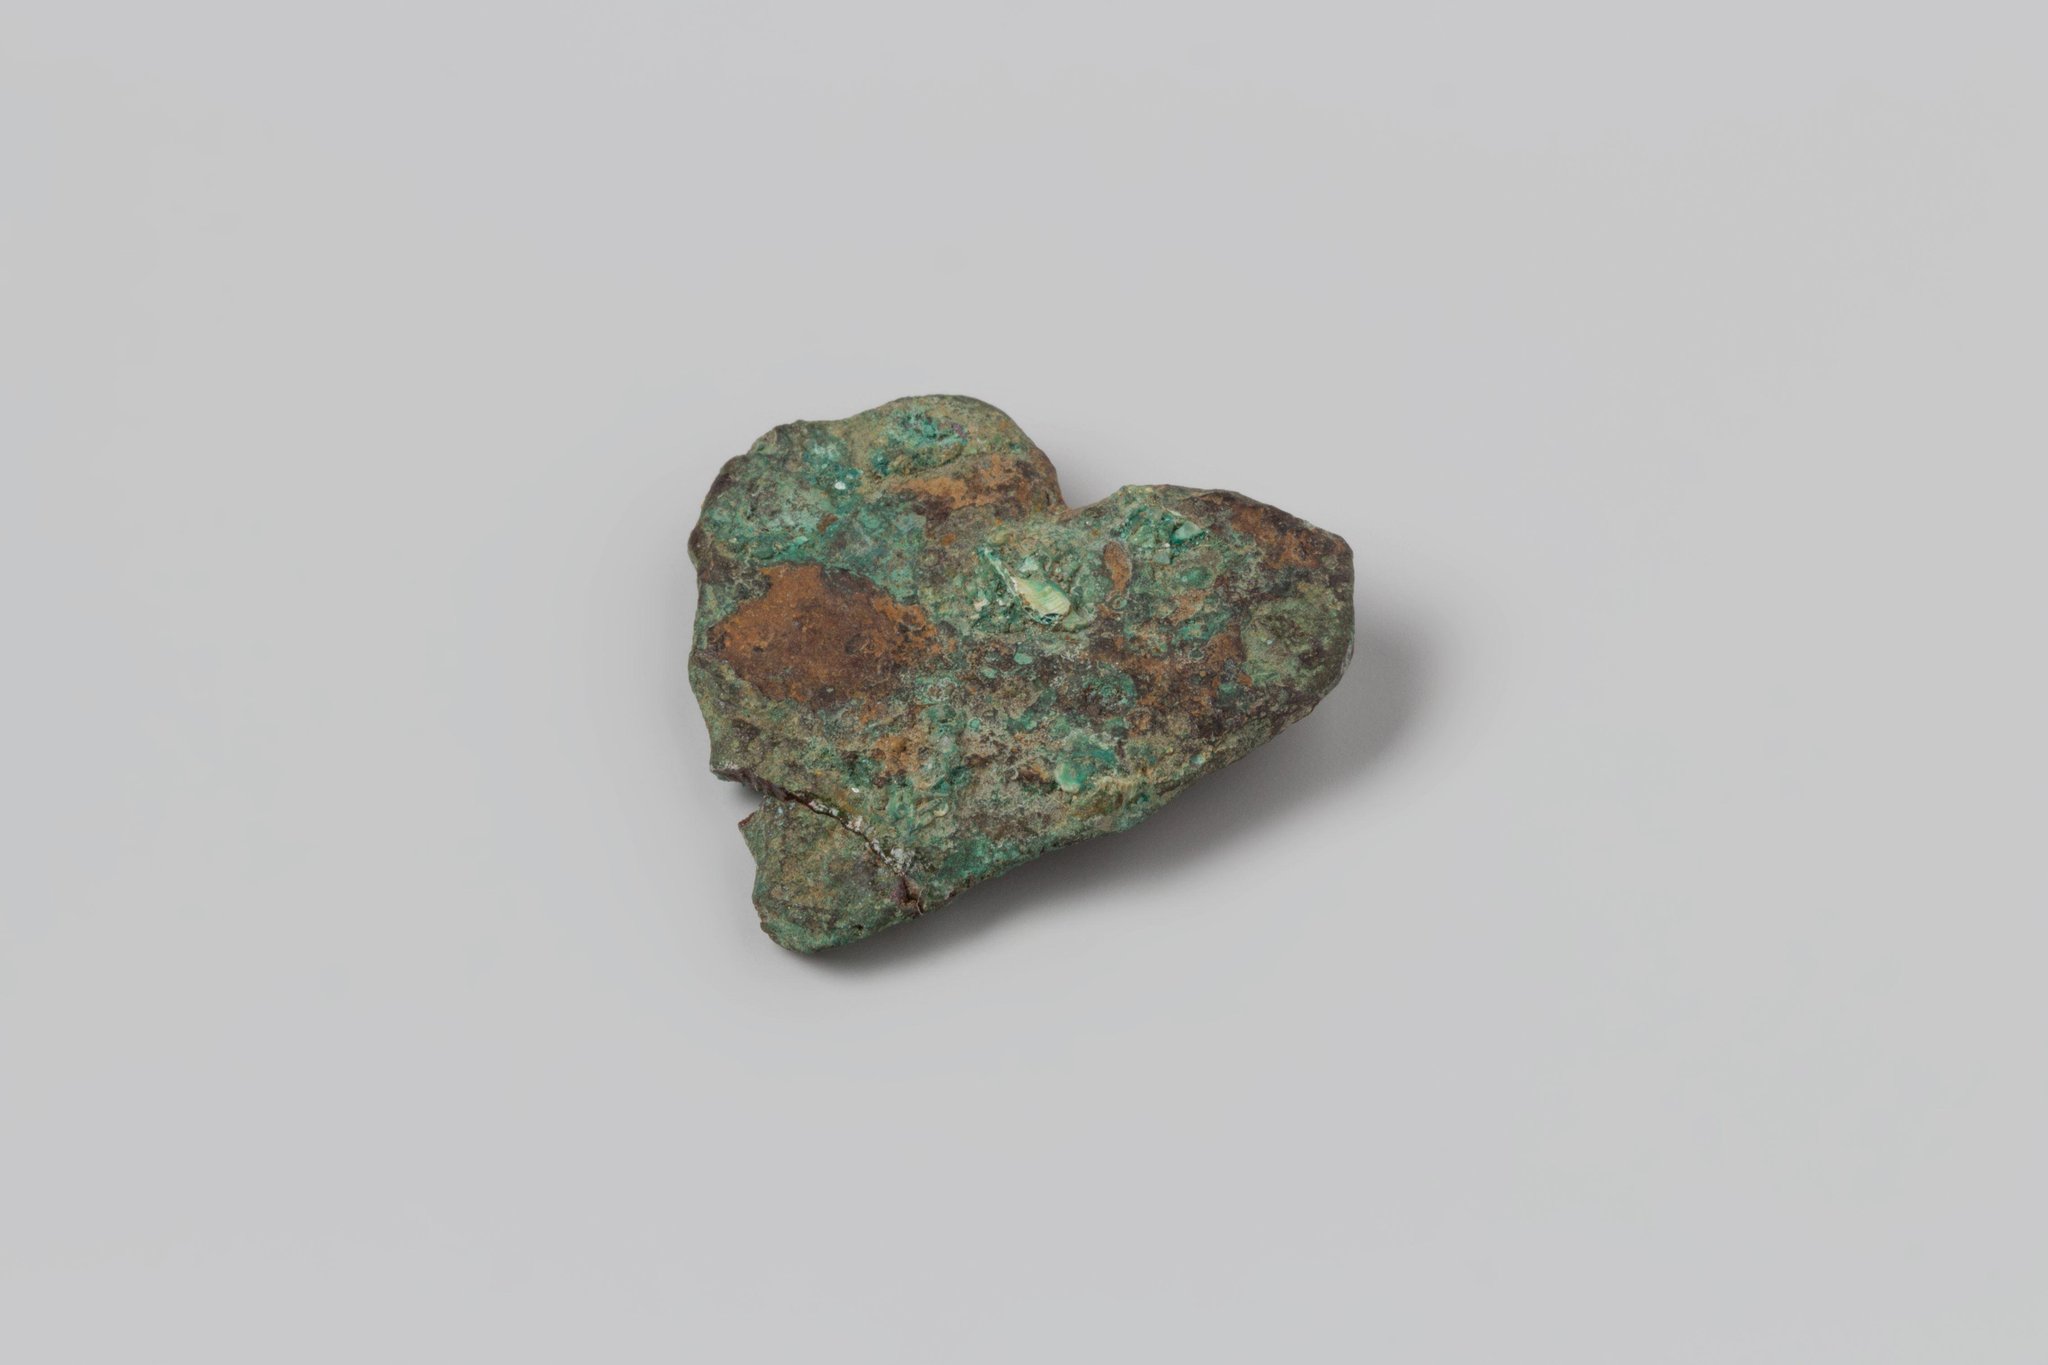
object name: decoratie onderscheiding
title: Decoratie uit het wrak van de Oost-Indiëvaarder Hollandia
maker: Anonymous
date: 1700-1743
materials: copper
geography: netherlands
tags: verenigde oostindische compagnie, hollandia (schip), annet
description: Decorative, general; fragm id. NG 1980-27H175.